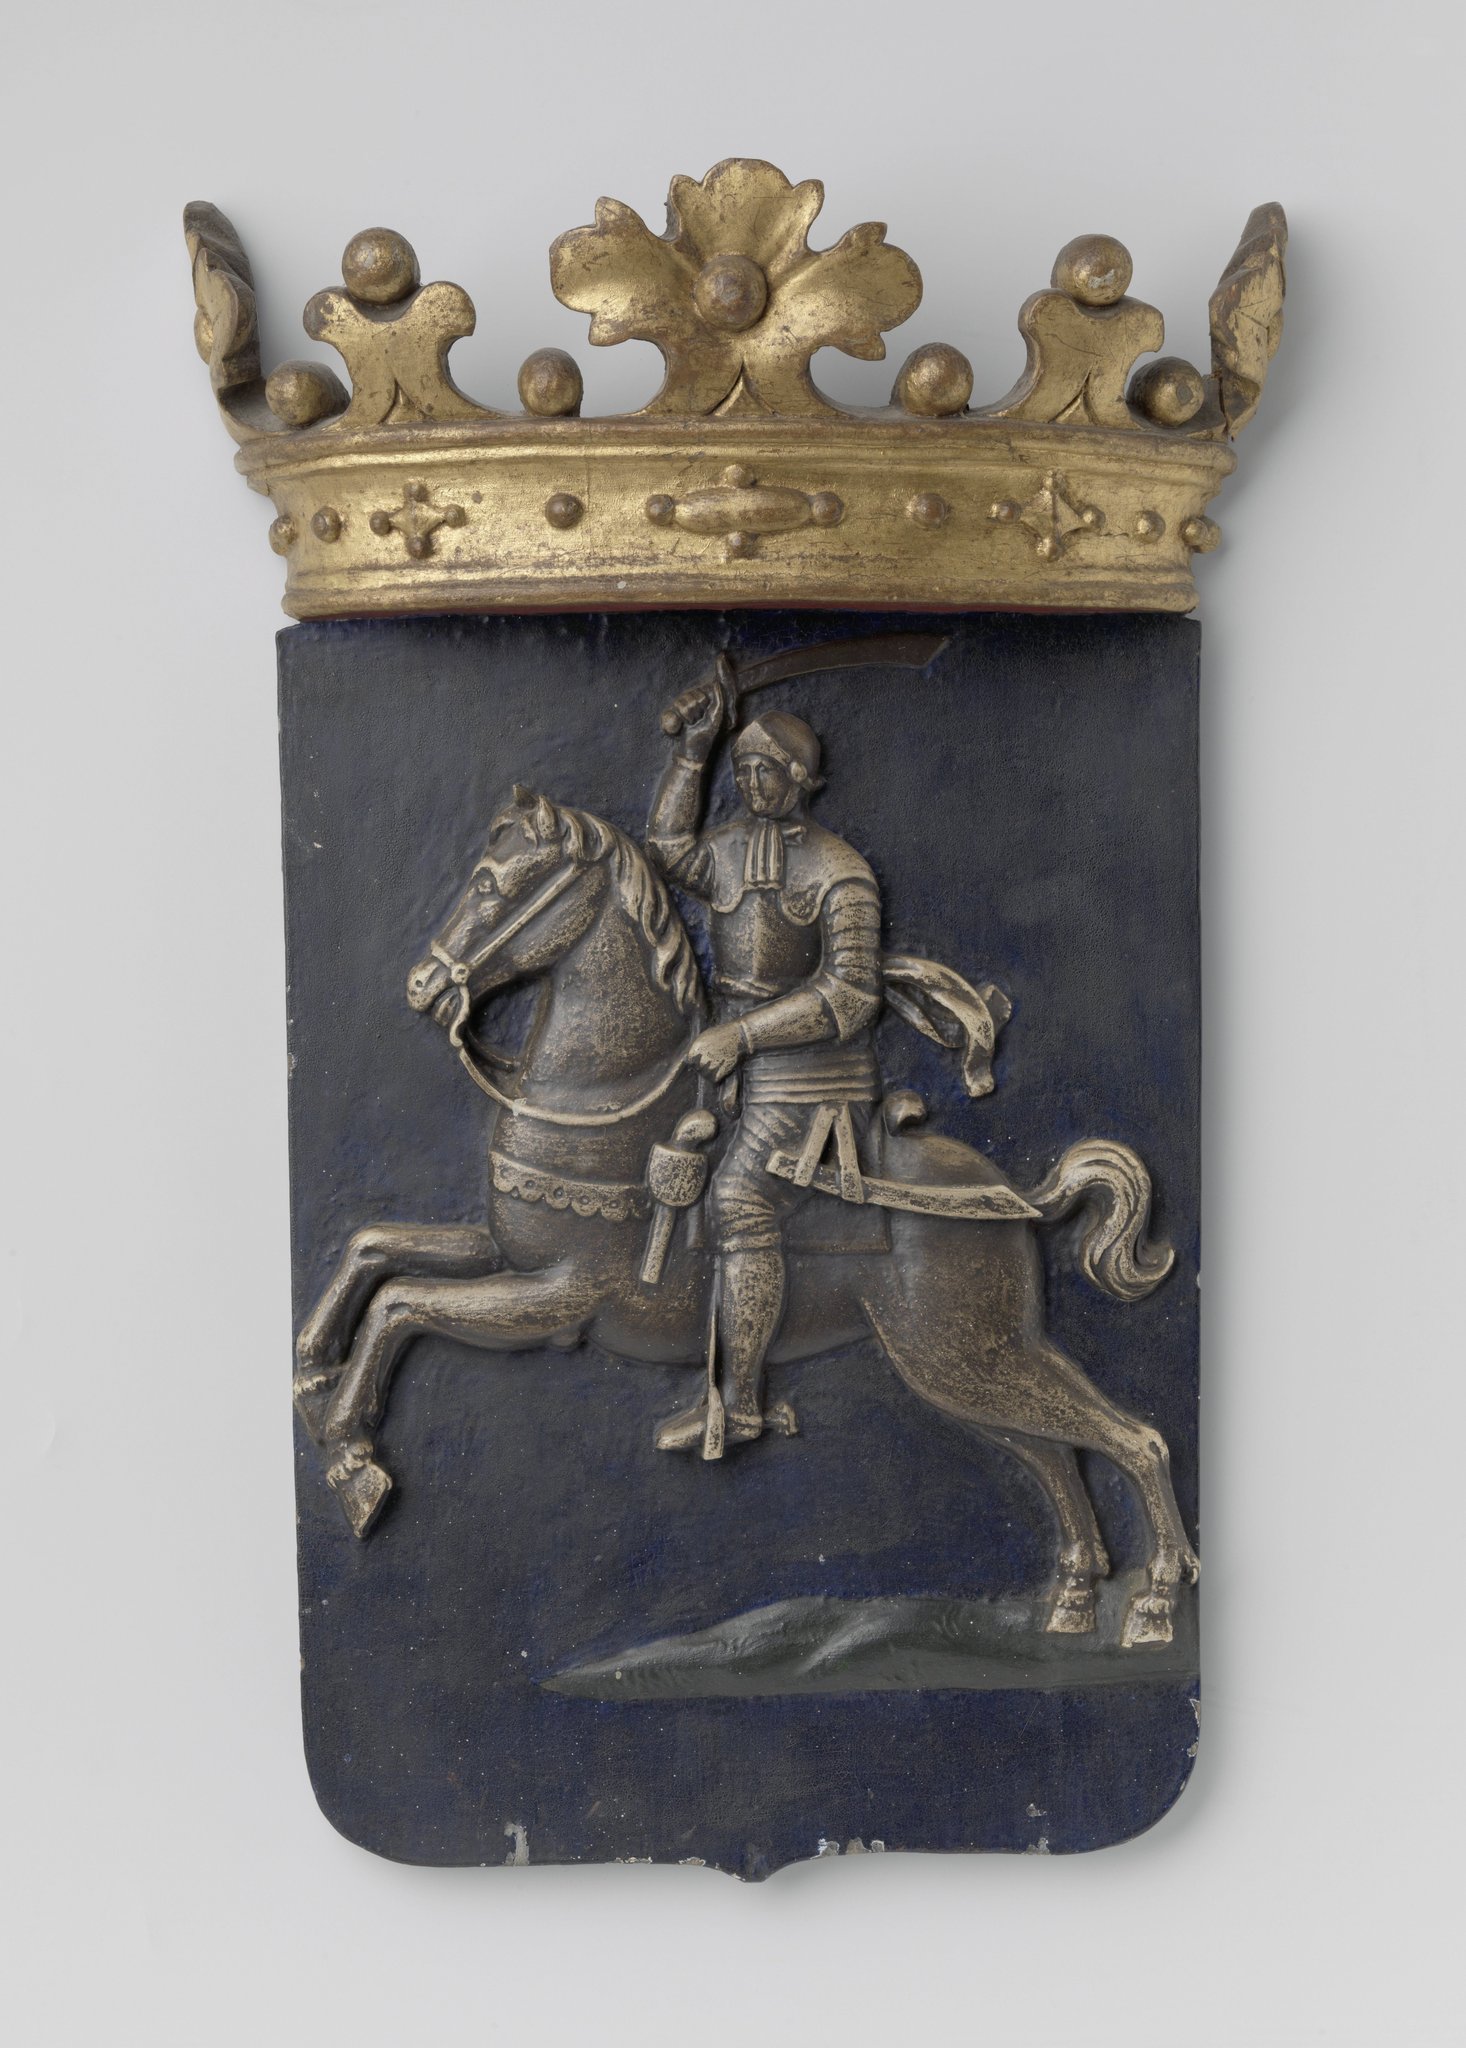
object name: shield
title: Het tweede kwartier van het wapen van Michiel Adriaenszoon de Ruyter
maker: Anonymous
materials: wood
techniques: polychromy, carving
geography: netherlands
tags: flushing, michiel adriaenszoon de ruyter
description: Arms of the De Ruyter family, made between 1676 and 1683. Michiel de Ruyter was a commoner by birth. In gratitude for his exploits against the Swedes, the king of Denmark ennobled the Dutch admiral in 1660. De Ruyter received a coat of arms of which the four quarters represented the Danish flag, a ship at sea, a gun and a horseman - a play on his name. The Spanish king awarded De Ruyter's son Engel a baronetcy in 1678. This added a heart-shaped shield with a lion to the family coat of arms.